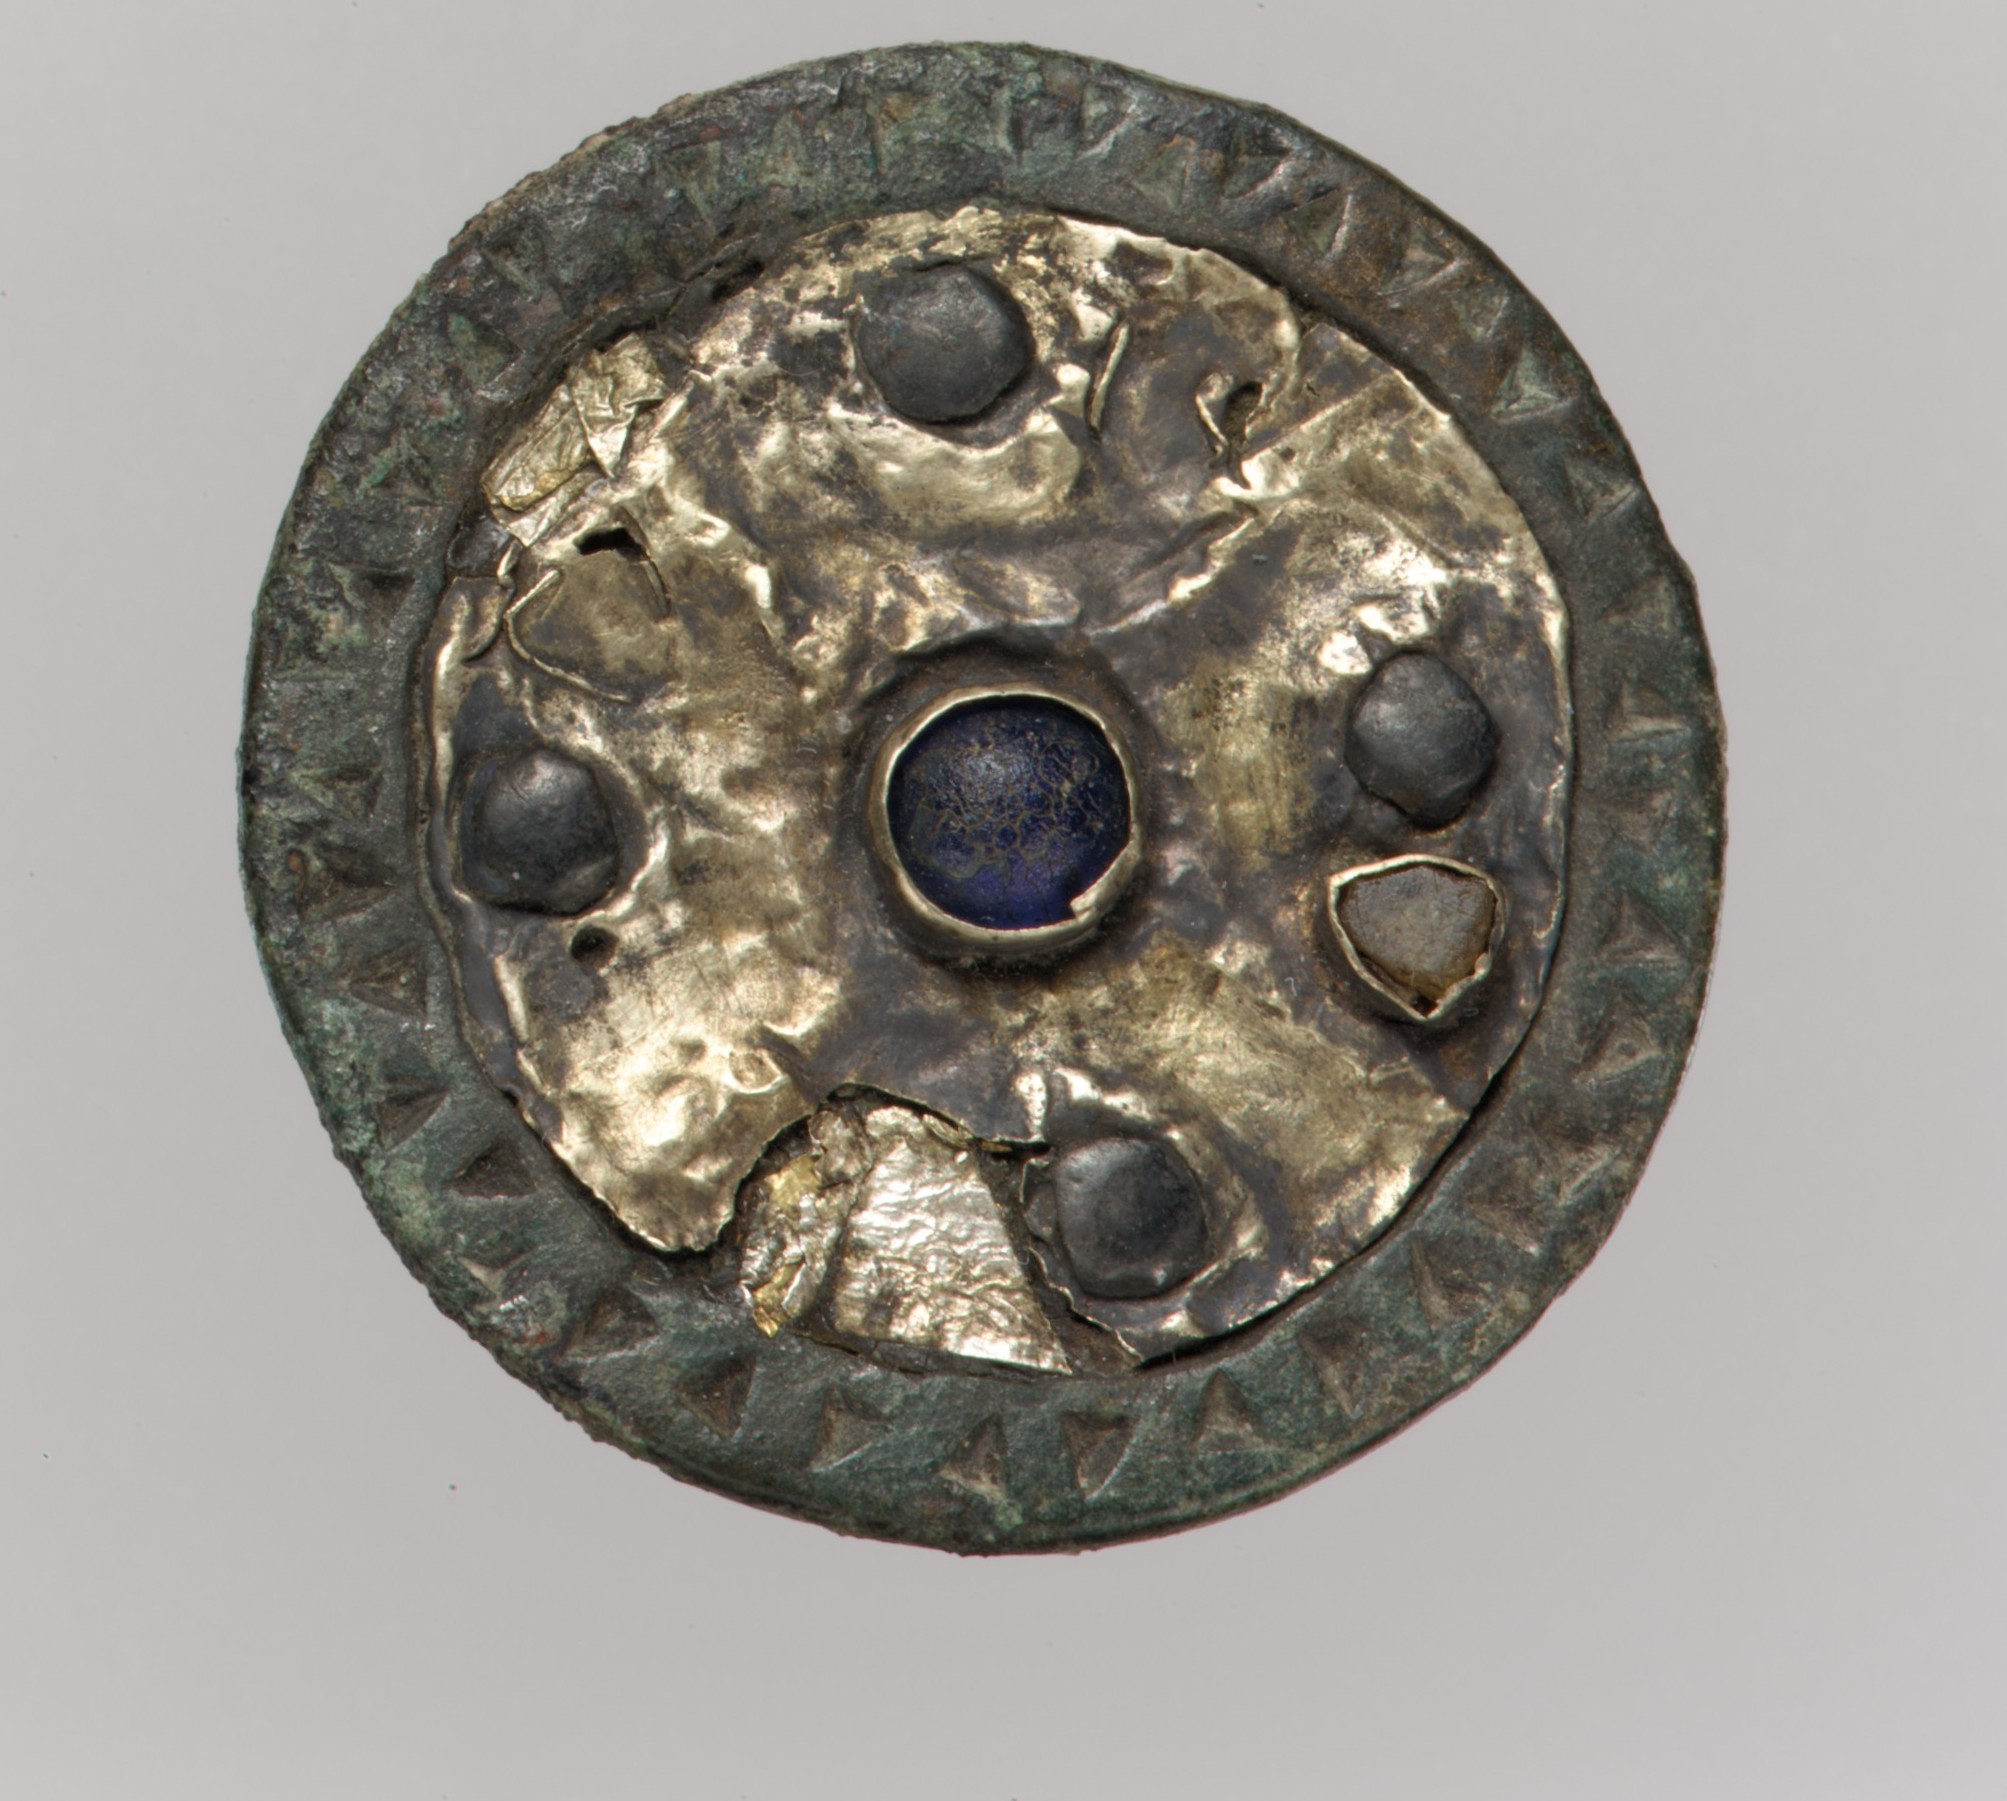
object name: brooch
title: Disk Brooch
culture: frankish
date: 601-700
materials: copper alloy, gold, iron, paste, metal